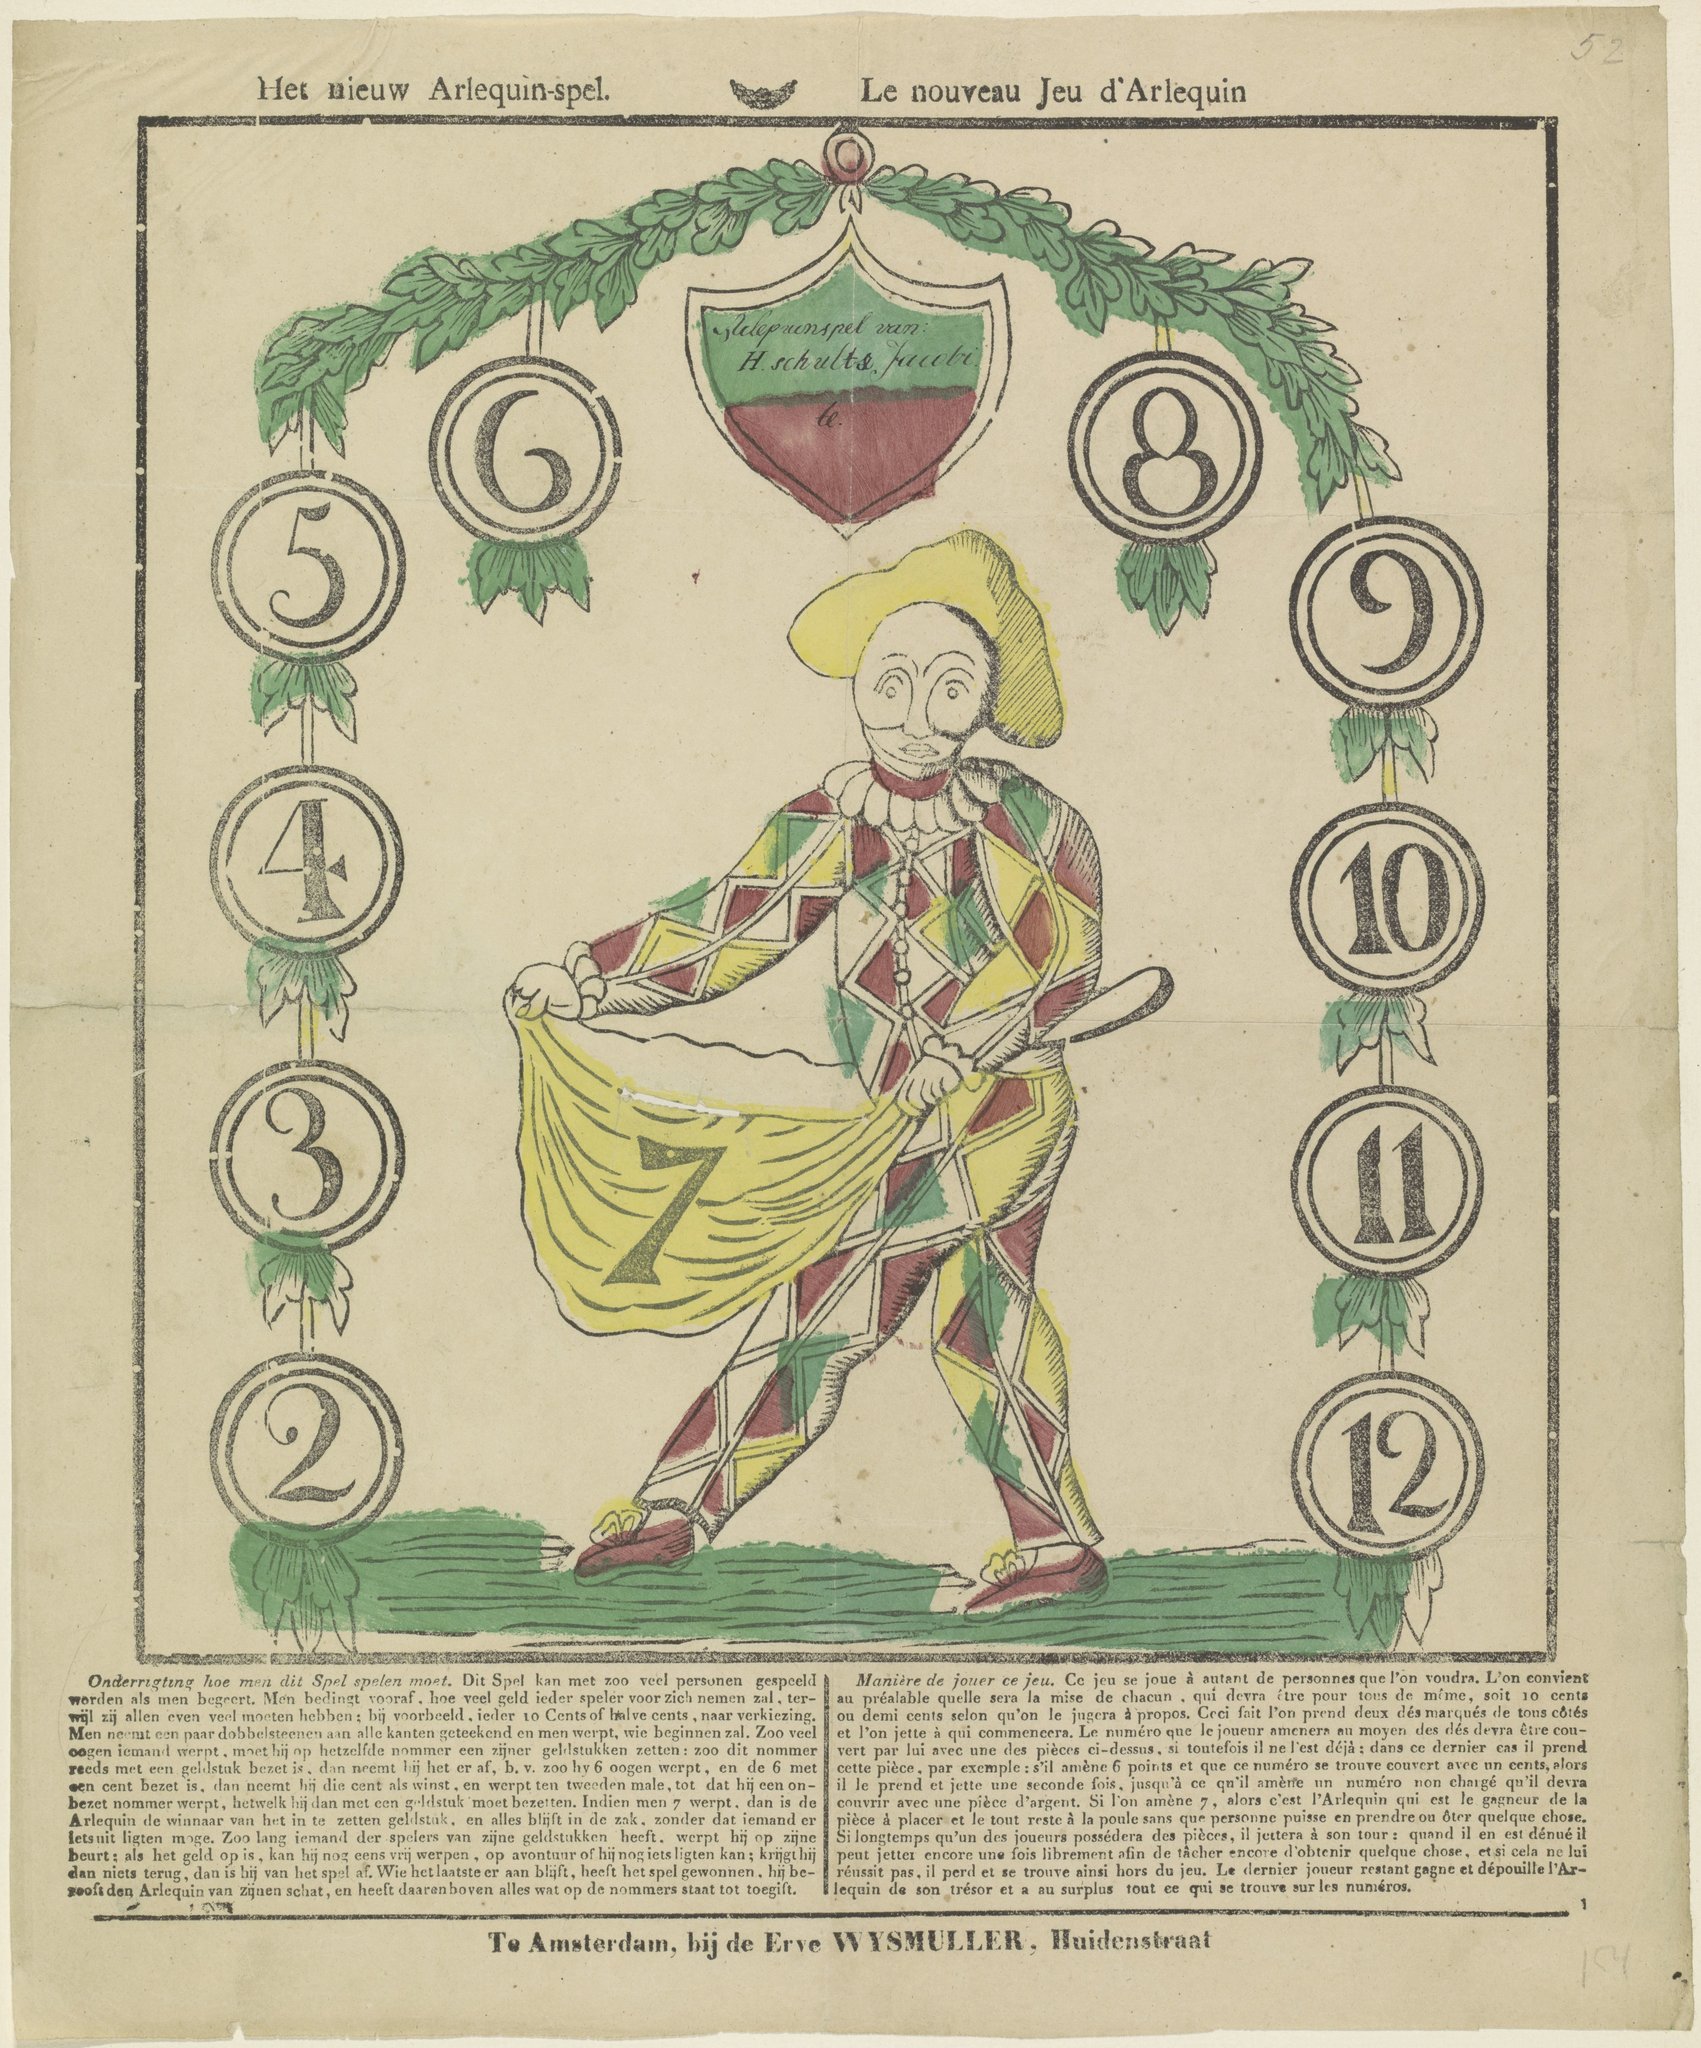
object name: popular print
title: Het nieuw arlequinspel / Le nouveau jeu d'arlequin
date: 1828-1913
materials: paper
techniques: colour, letterpress printing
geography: turnhout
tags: board-games of chance, types in 'commedia dell'arte': harlequin, board-games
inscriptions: inscription: ‘Arlepuinspel [sic] van: / H. Schultsz Jacobi / te.’, collector's mark: Lugt 2760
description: Bordspel met in het midden van het speelveld een harlekijn die in zijn geopende handen een zak houdt met daarop het cijfer 7. Rondom hem een guirlande waaraan medaillons hangen met de cijfers 2 tot en met 12. Bovenaan in het midden een schild. Onder de voorstelling de spelregels in het Nederlands en in het Frans in twee kolommen. Genummerd midden boven: (N. 52).